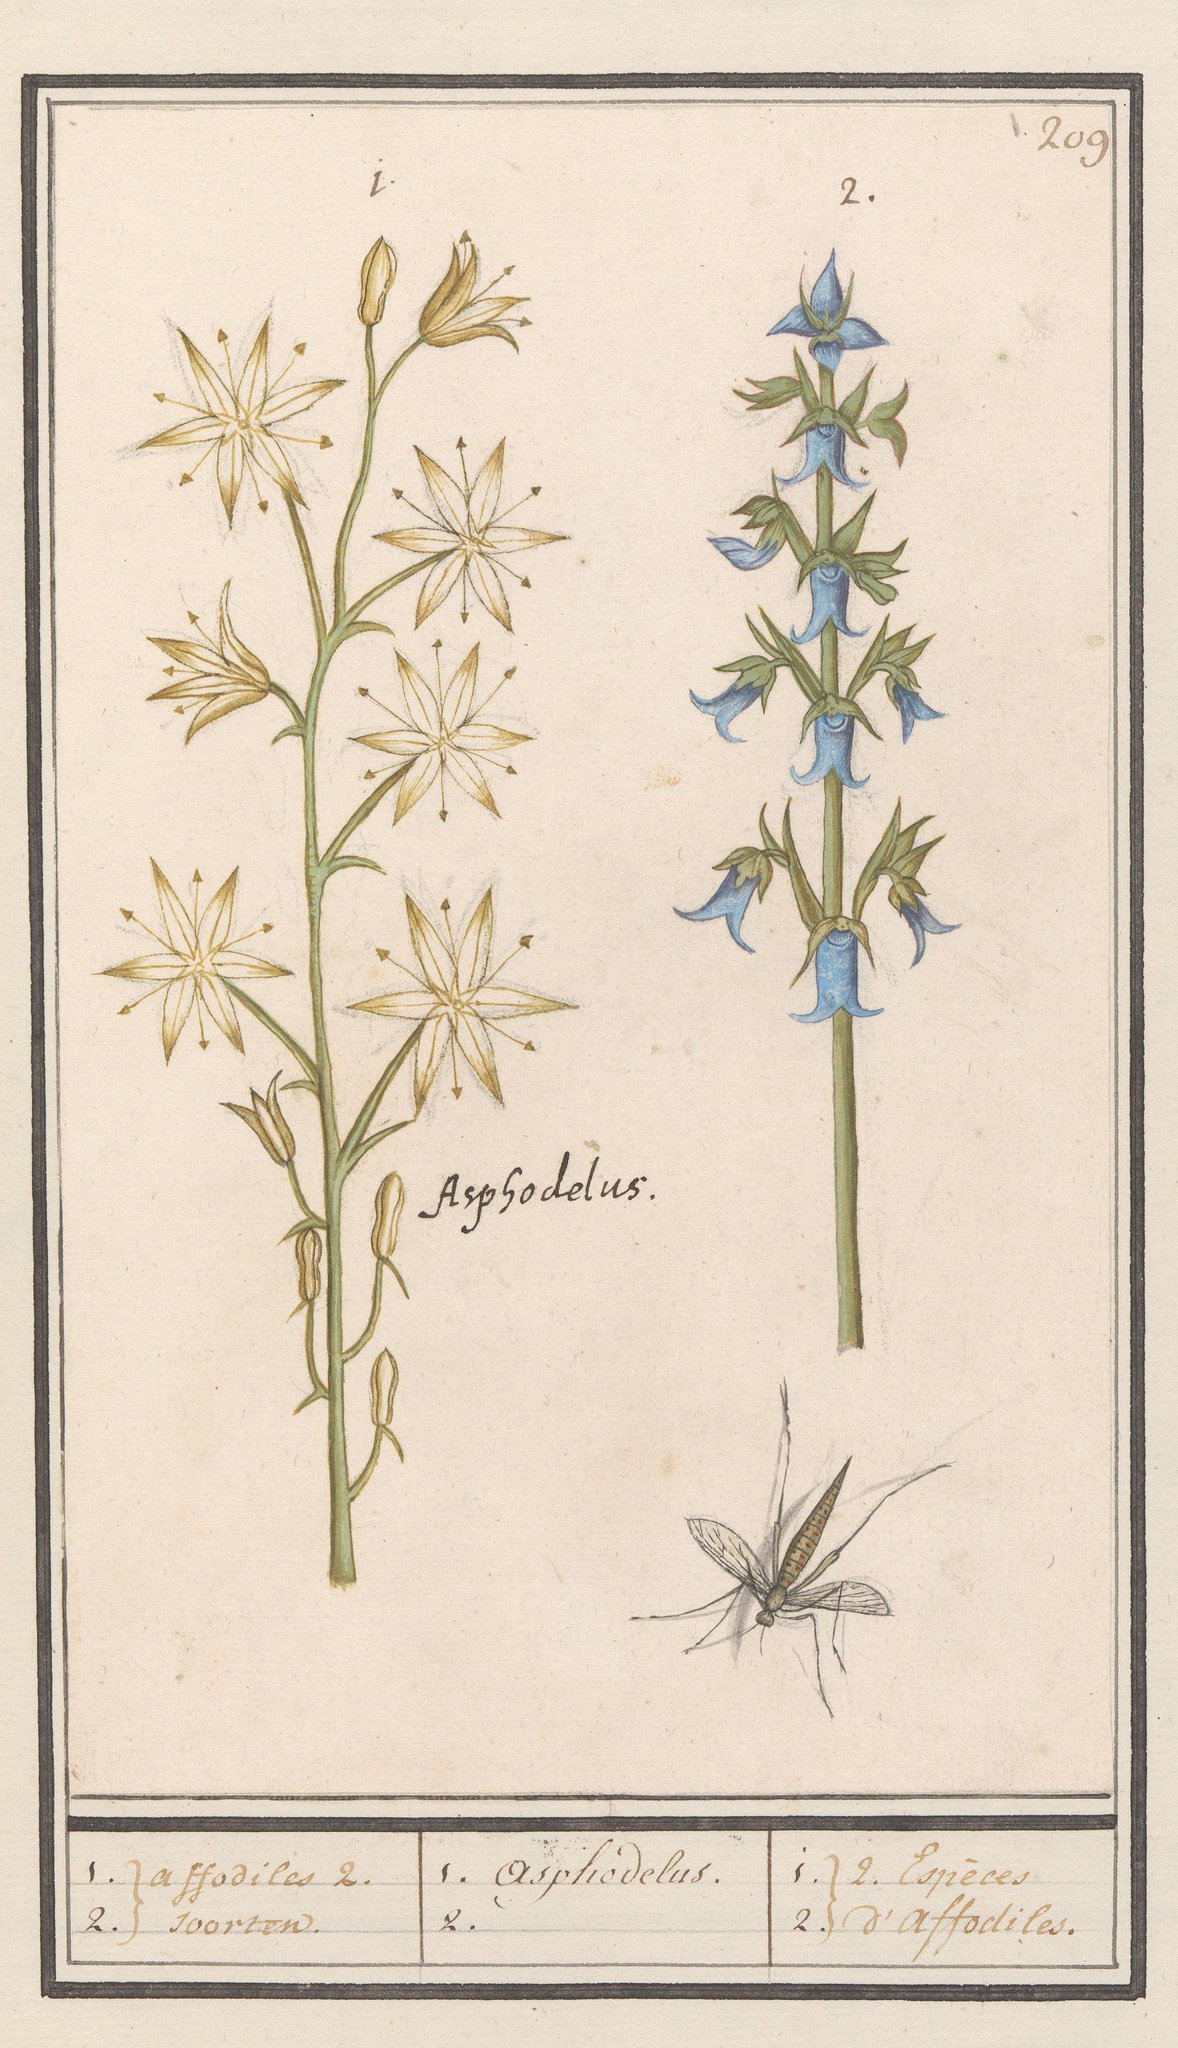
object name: drawing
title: 1.2. affodiles 2 soorten / 1. Asphodelus. 2. / 1.2. 2 Espèces d'affodiles.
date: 1596-1610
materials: chalk, paint, ink, paper, watercolor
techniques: brush, pen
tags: flowers: campanula, flowers: asphodelus, insects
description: Affodil en (waarschijnlijk) Ruig klokje, hierbij ook een langpootmug. Genummerd rechtsboven: 209. Met de Latijnse naam. Onderdeel van het derde album met tekeningen van bloemen en planten. Tiende van twaalf albums met tekeningen van dieren, vogels en planten bekend rond 1600, gemaakt in opdracht van keizer Rudolf II. Met toelichting in Nederlands, Latijn en Frans.